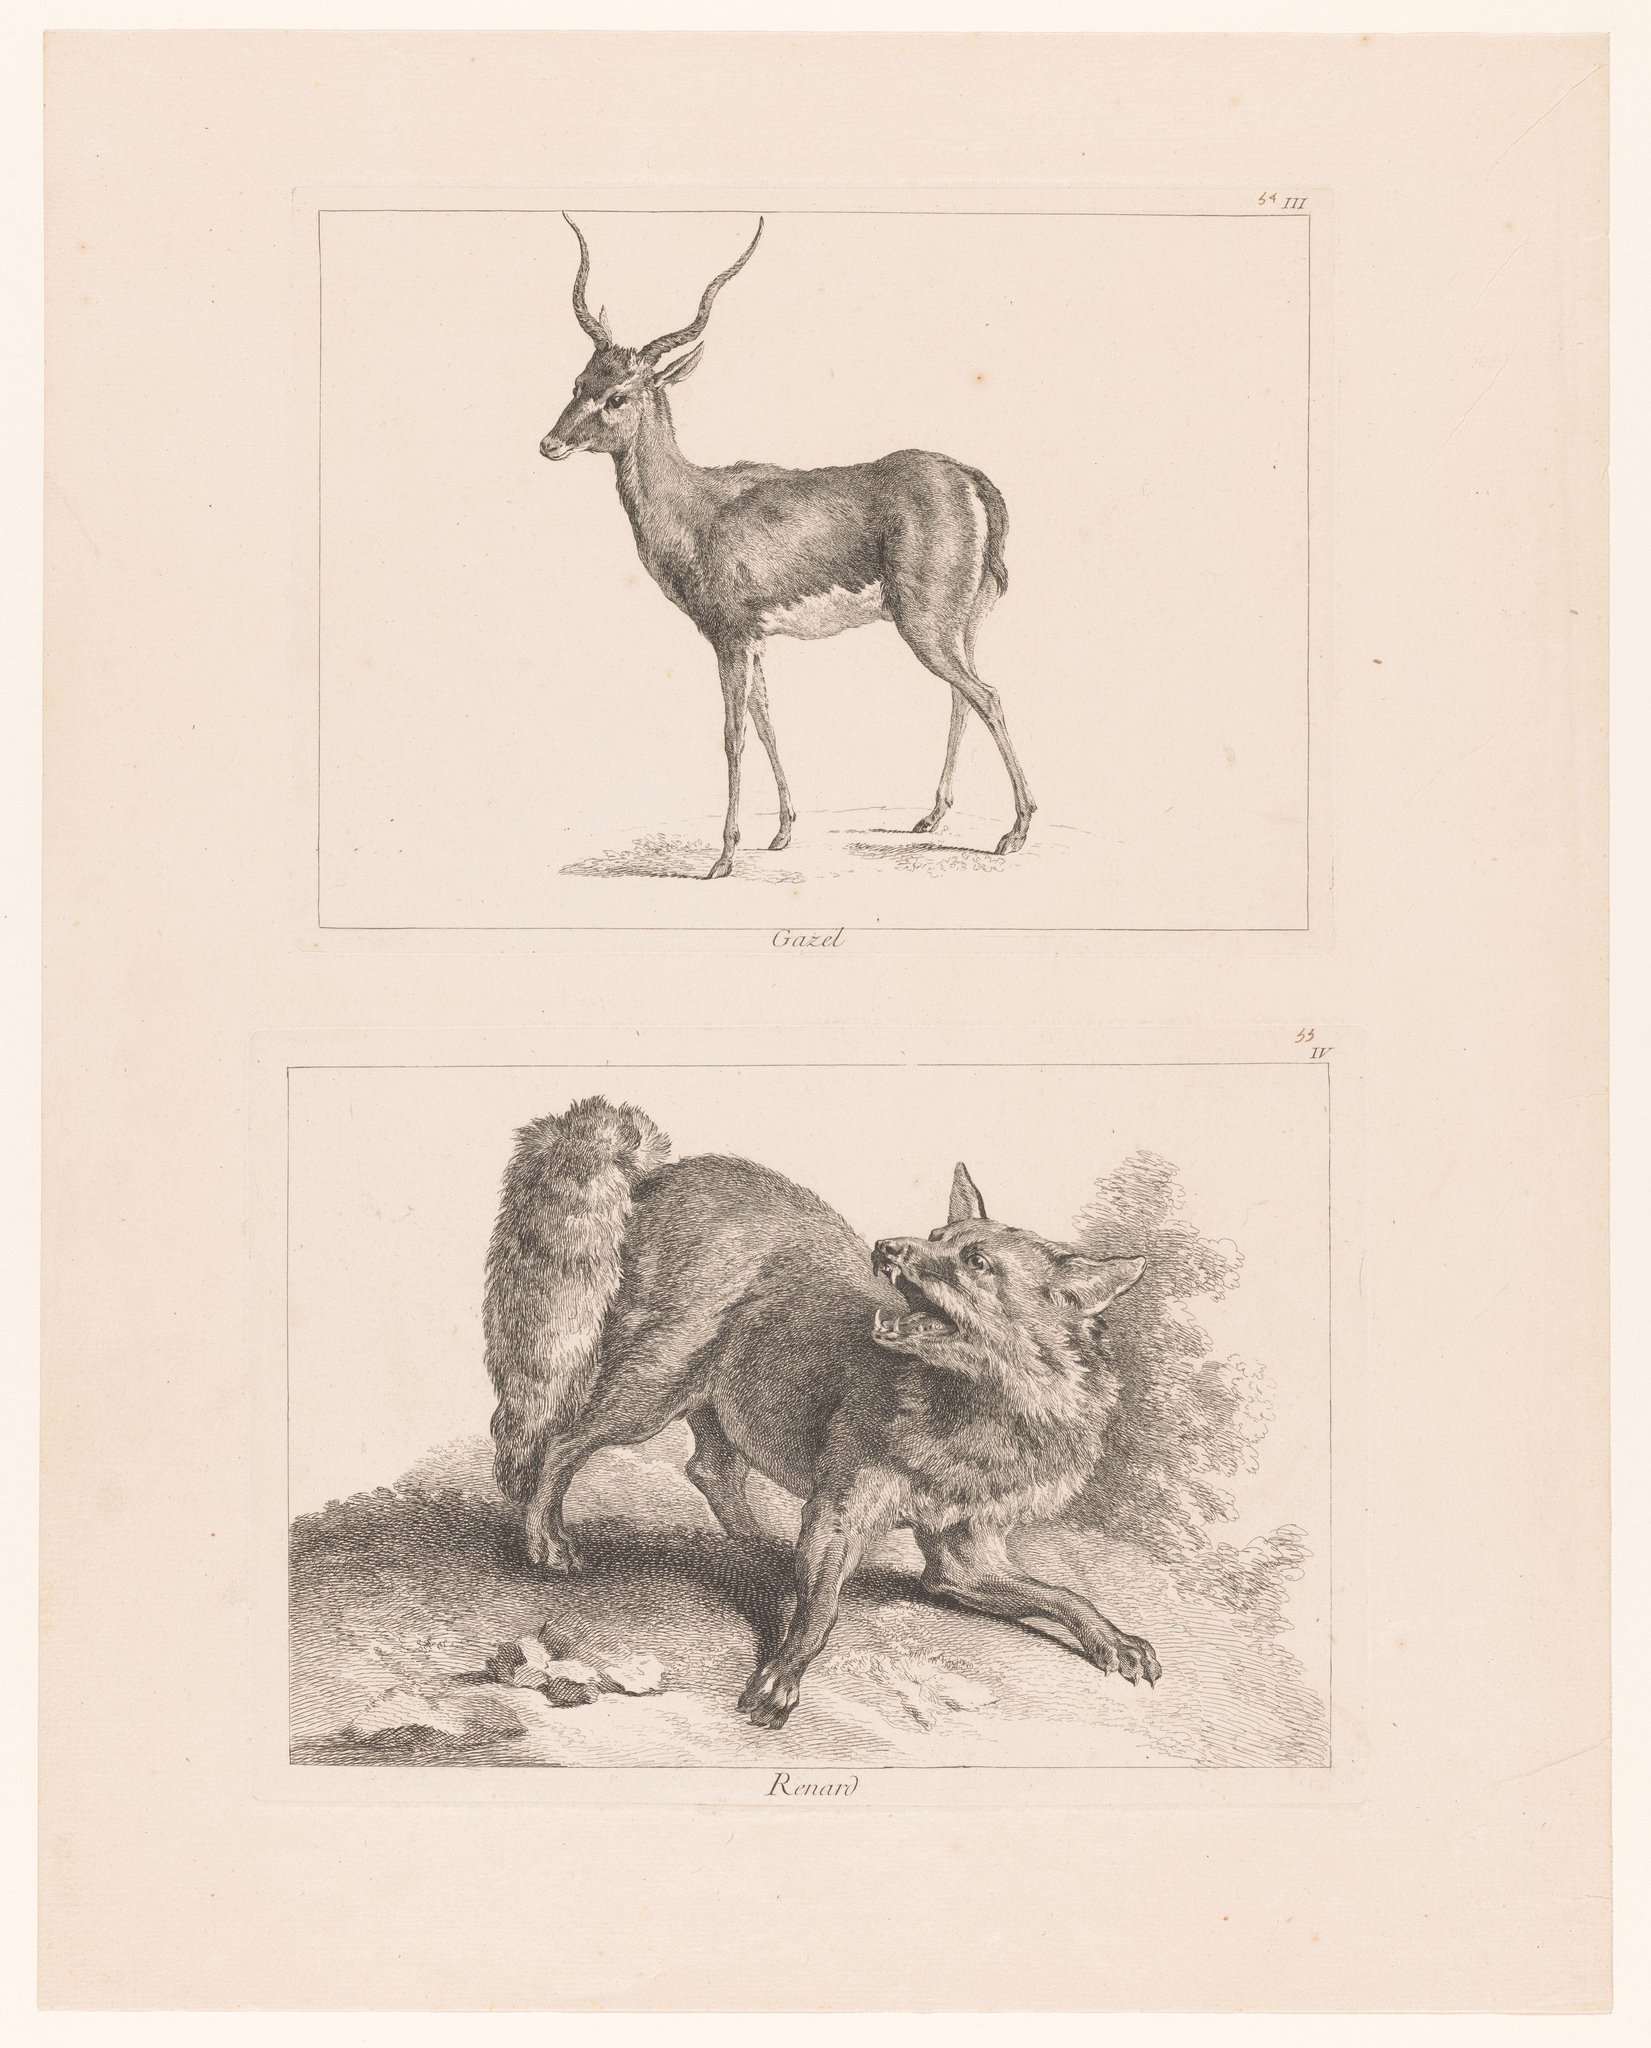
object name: print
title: Gazel / Renard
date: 1740-1745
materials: paper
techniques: etching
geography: stockholm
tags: fox hunting, hunt ~ hoofed animals, hoofed animals: gazelle, beasts of prey, predatory animals: fox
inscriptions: collector's mark: Lugt 240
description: Blad met twee platen. Bovenste plaat: een gazelle (nr. III). Onderste plaat: een vos (nr. IV). Onderdeel van een serie van twaalf prenten van dieren gerelateerd aan de jacht.